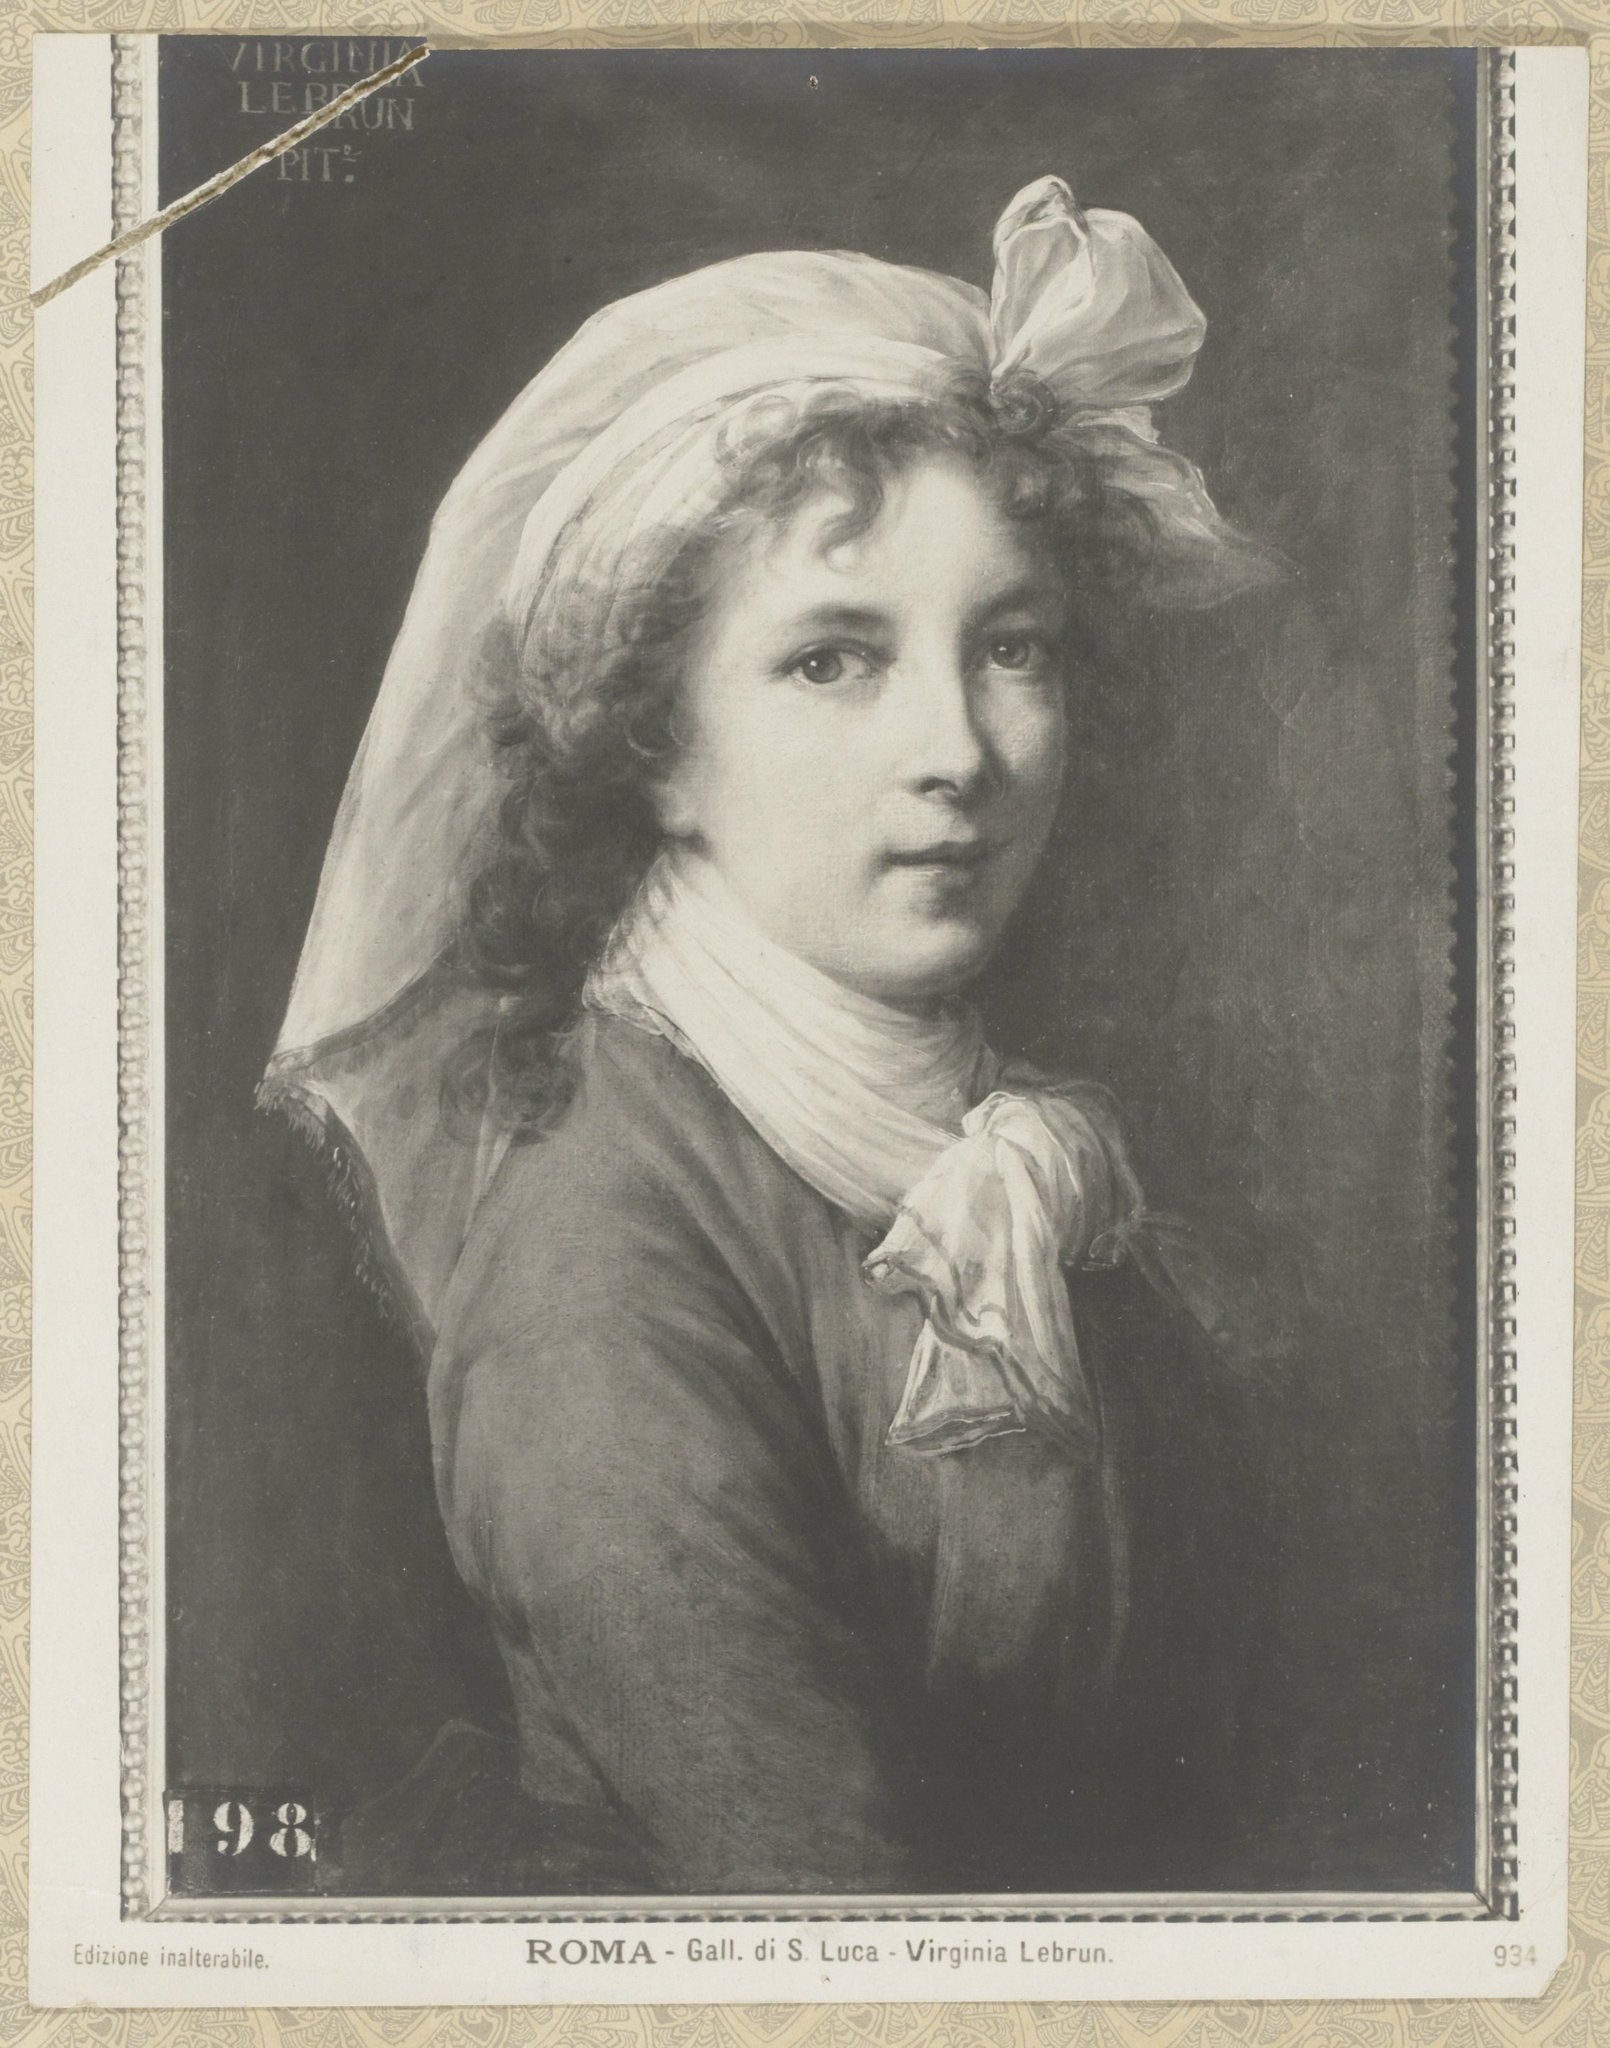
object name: photograph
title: ROMA - Gall. di S. Luca - Virginia Lebrun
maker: Anonymous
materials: photographic support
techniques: gelatin silver print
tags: adult woman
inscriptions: number: ‘198’, inscription: ‘Edizione inalterabile’, number: ‘934’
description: Onderdeel van Fotoalbum van een reis door Zuid-Europa en het Midden-Oosten.